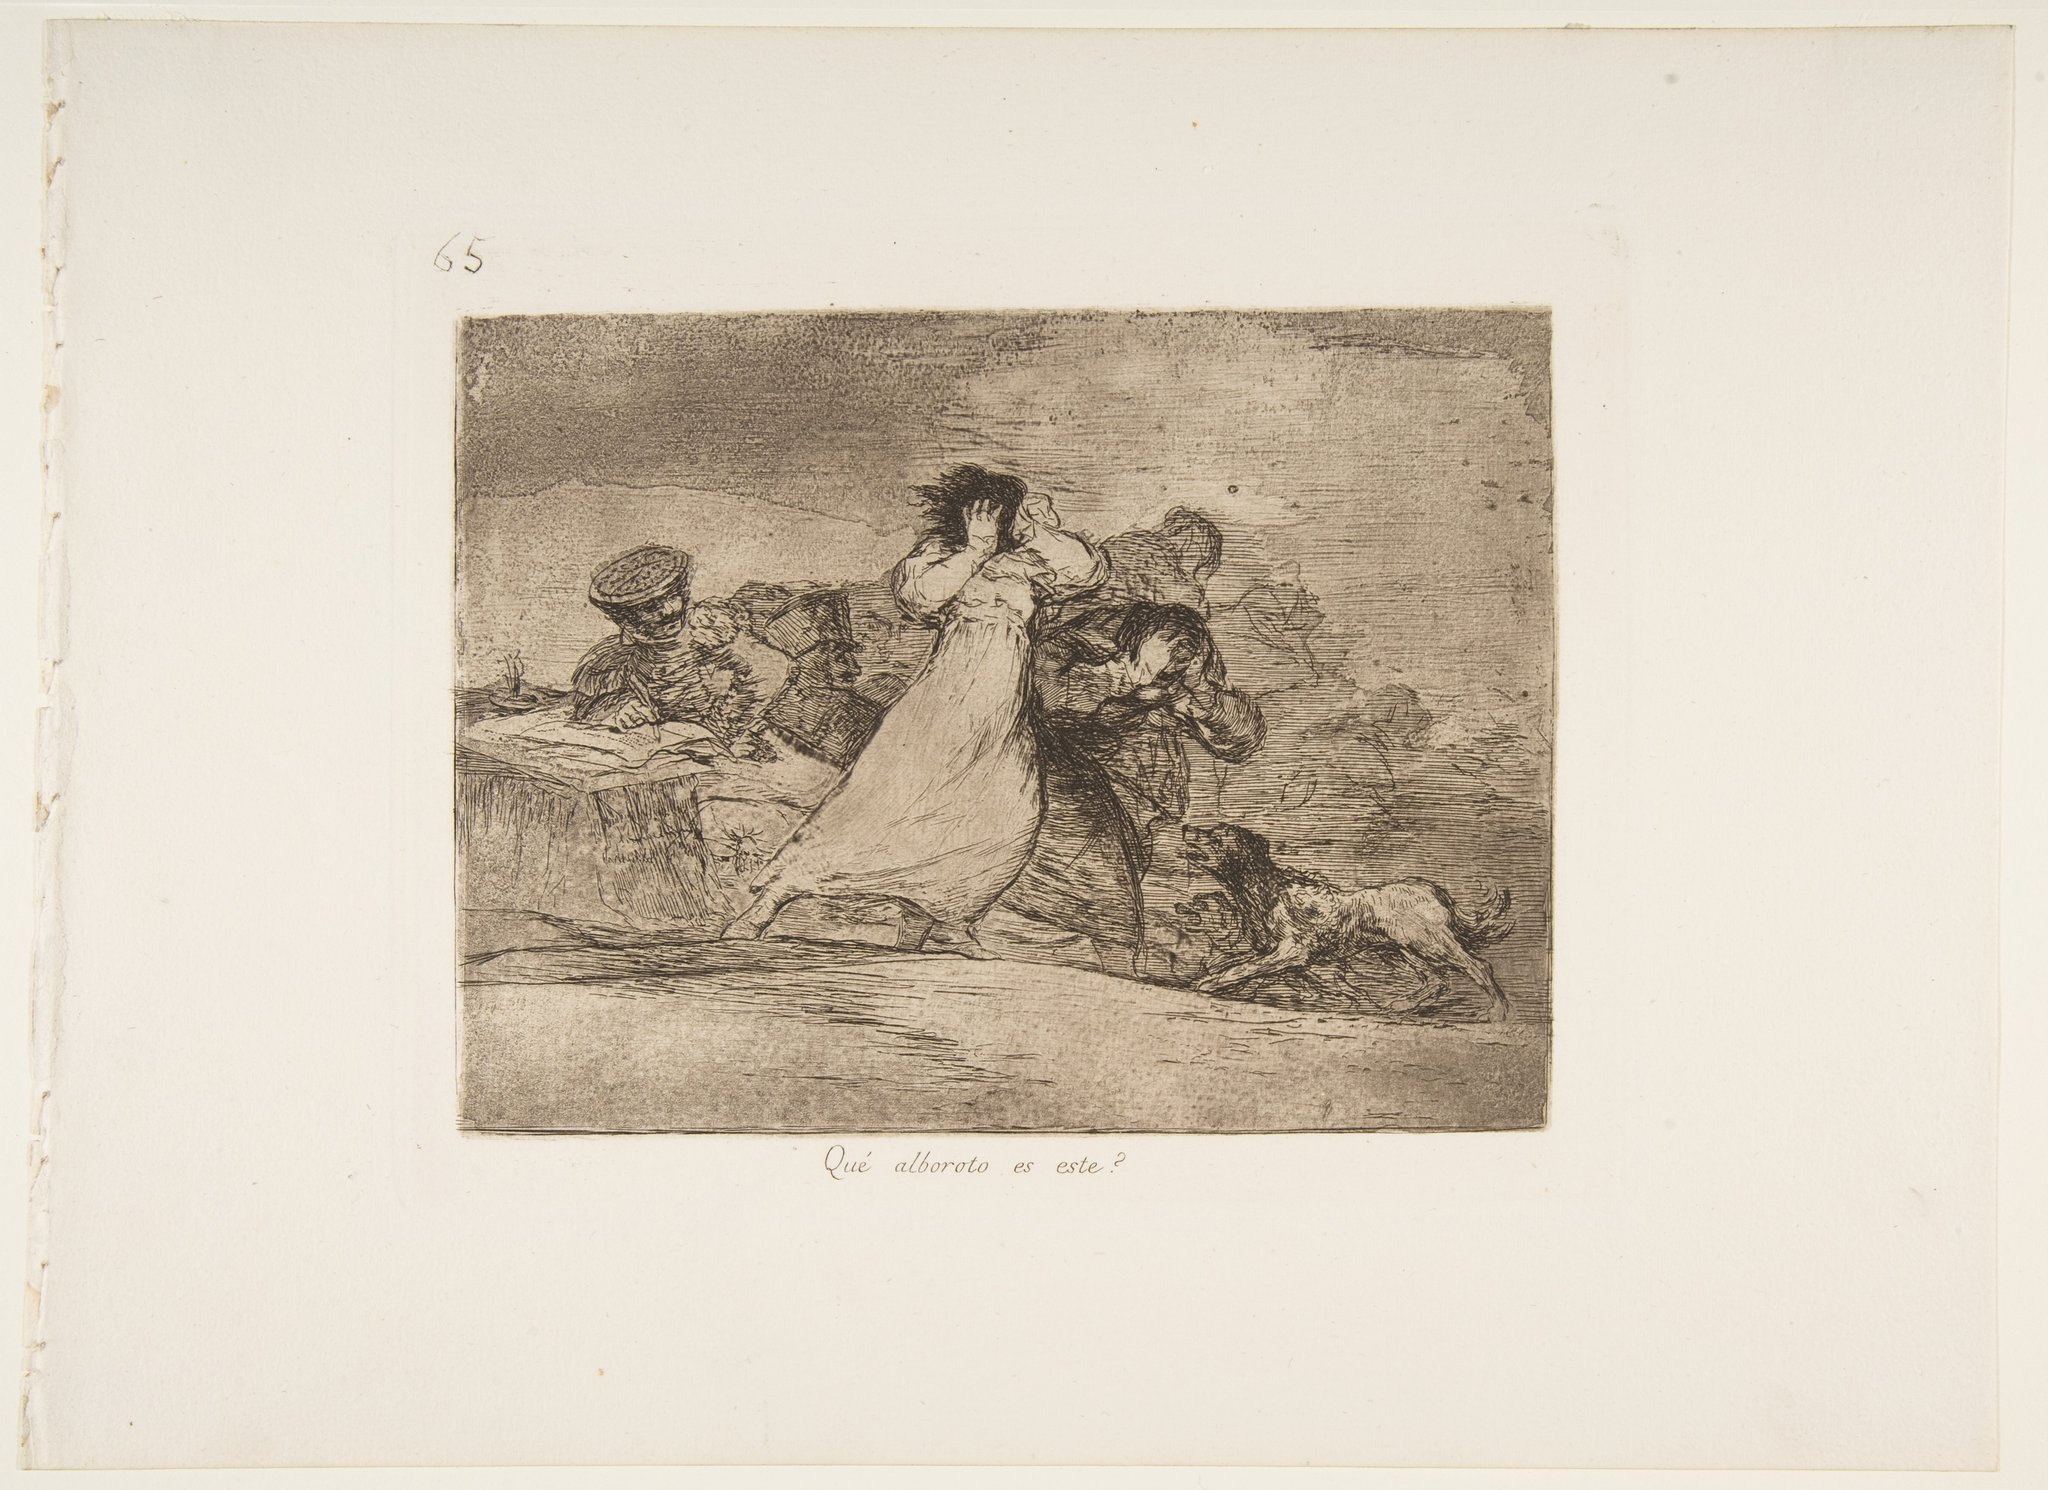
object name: print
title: Plate 65 from "The Disasters of War" (Los Desastres de la Guerra): 'What is this hubbub?' (Qué alboroto es este?)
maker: goya (francisco de goya y lucientes)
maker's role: artist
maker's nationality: spanish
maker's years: 1746-1828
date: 1814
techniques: aquatint, engraving, burnishing, etching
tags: men,women,dogs